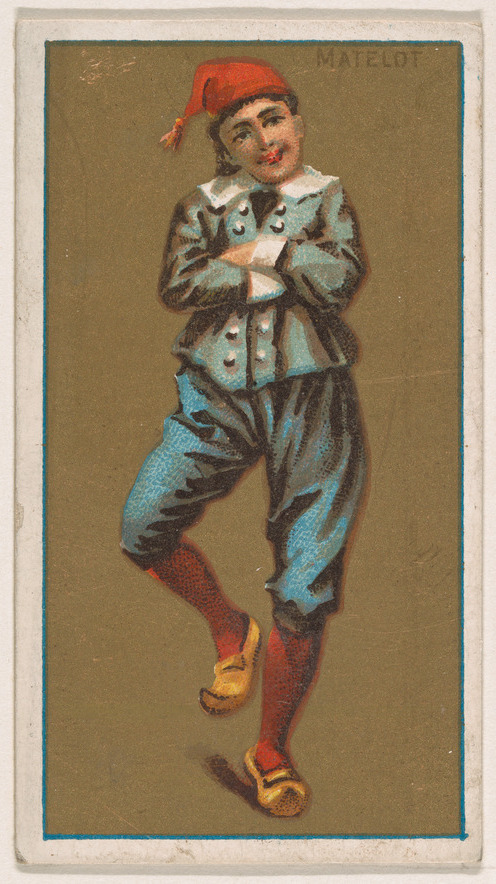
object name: print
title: Matelot, from National Dances (N225, Type 1) issued by Kinney Bros.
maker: kinney brothers tobacco company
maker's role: publisher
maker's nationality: american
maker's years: 1869-2011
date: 1889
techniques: color lithograph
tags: men,dancing